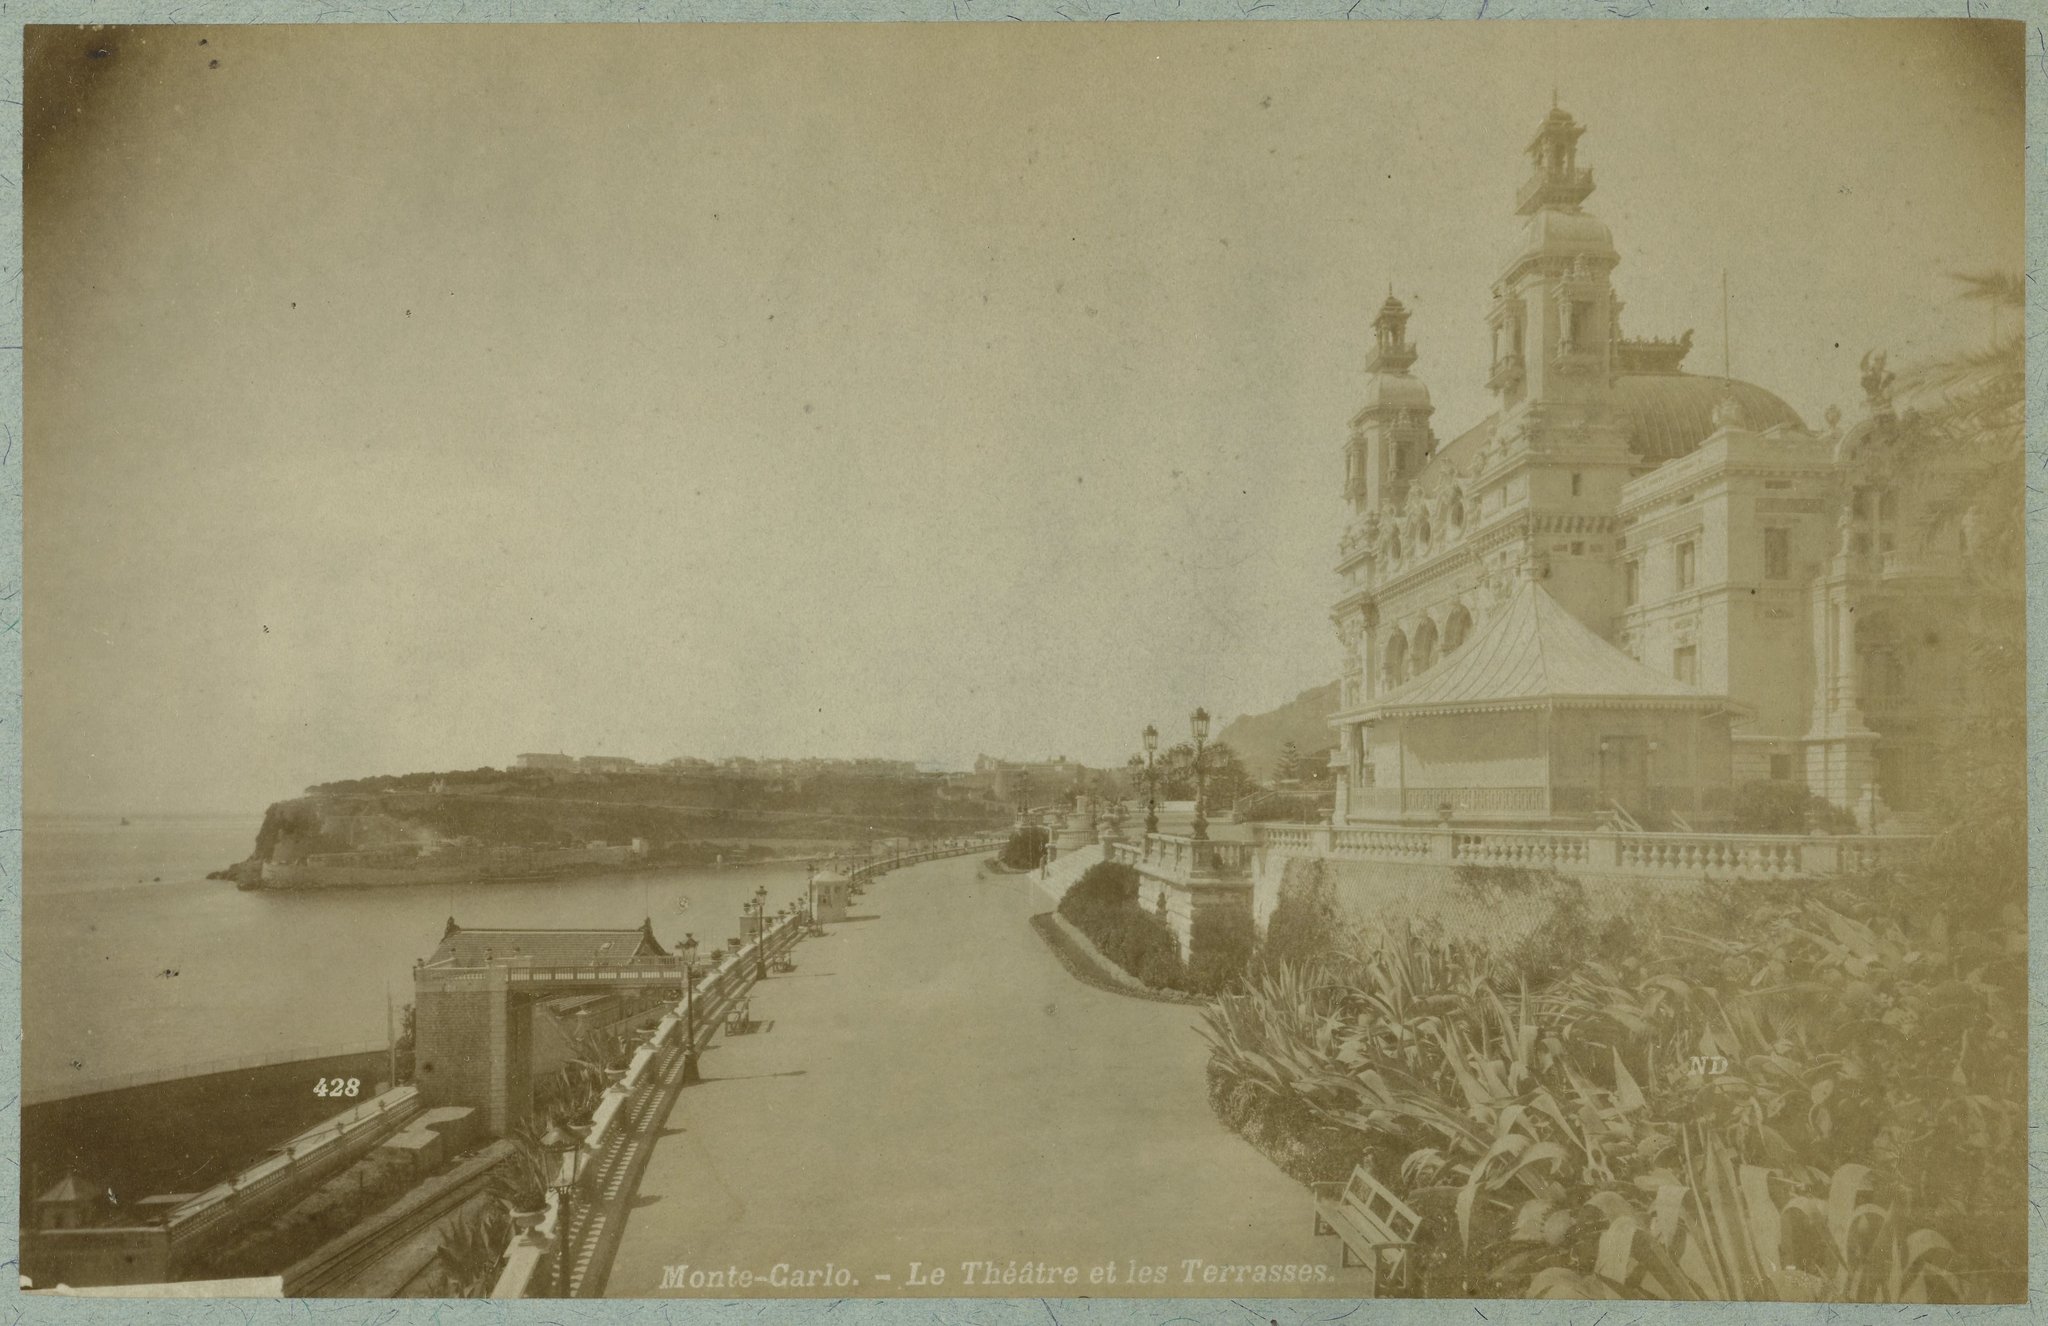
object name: photograph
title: Monte-Carlo. - Le Théâtre et les Terrasses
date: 1863-1891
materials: cardboard, paper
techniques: albumen print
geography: monte carlo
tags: gulf, bay, avenue, boulevard, promenade, esplanade, opera house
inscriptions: inscription: ‘428/ Monte-Carlo. - Le Théâtre et les Terrasses/ ND’